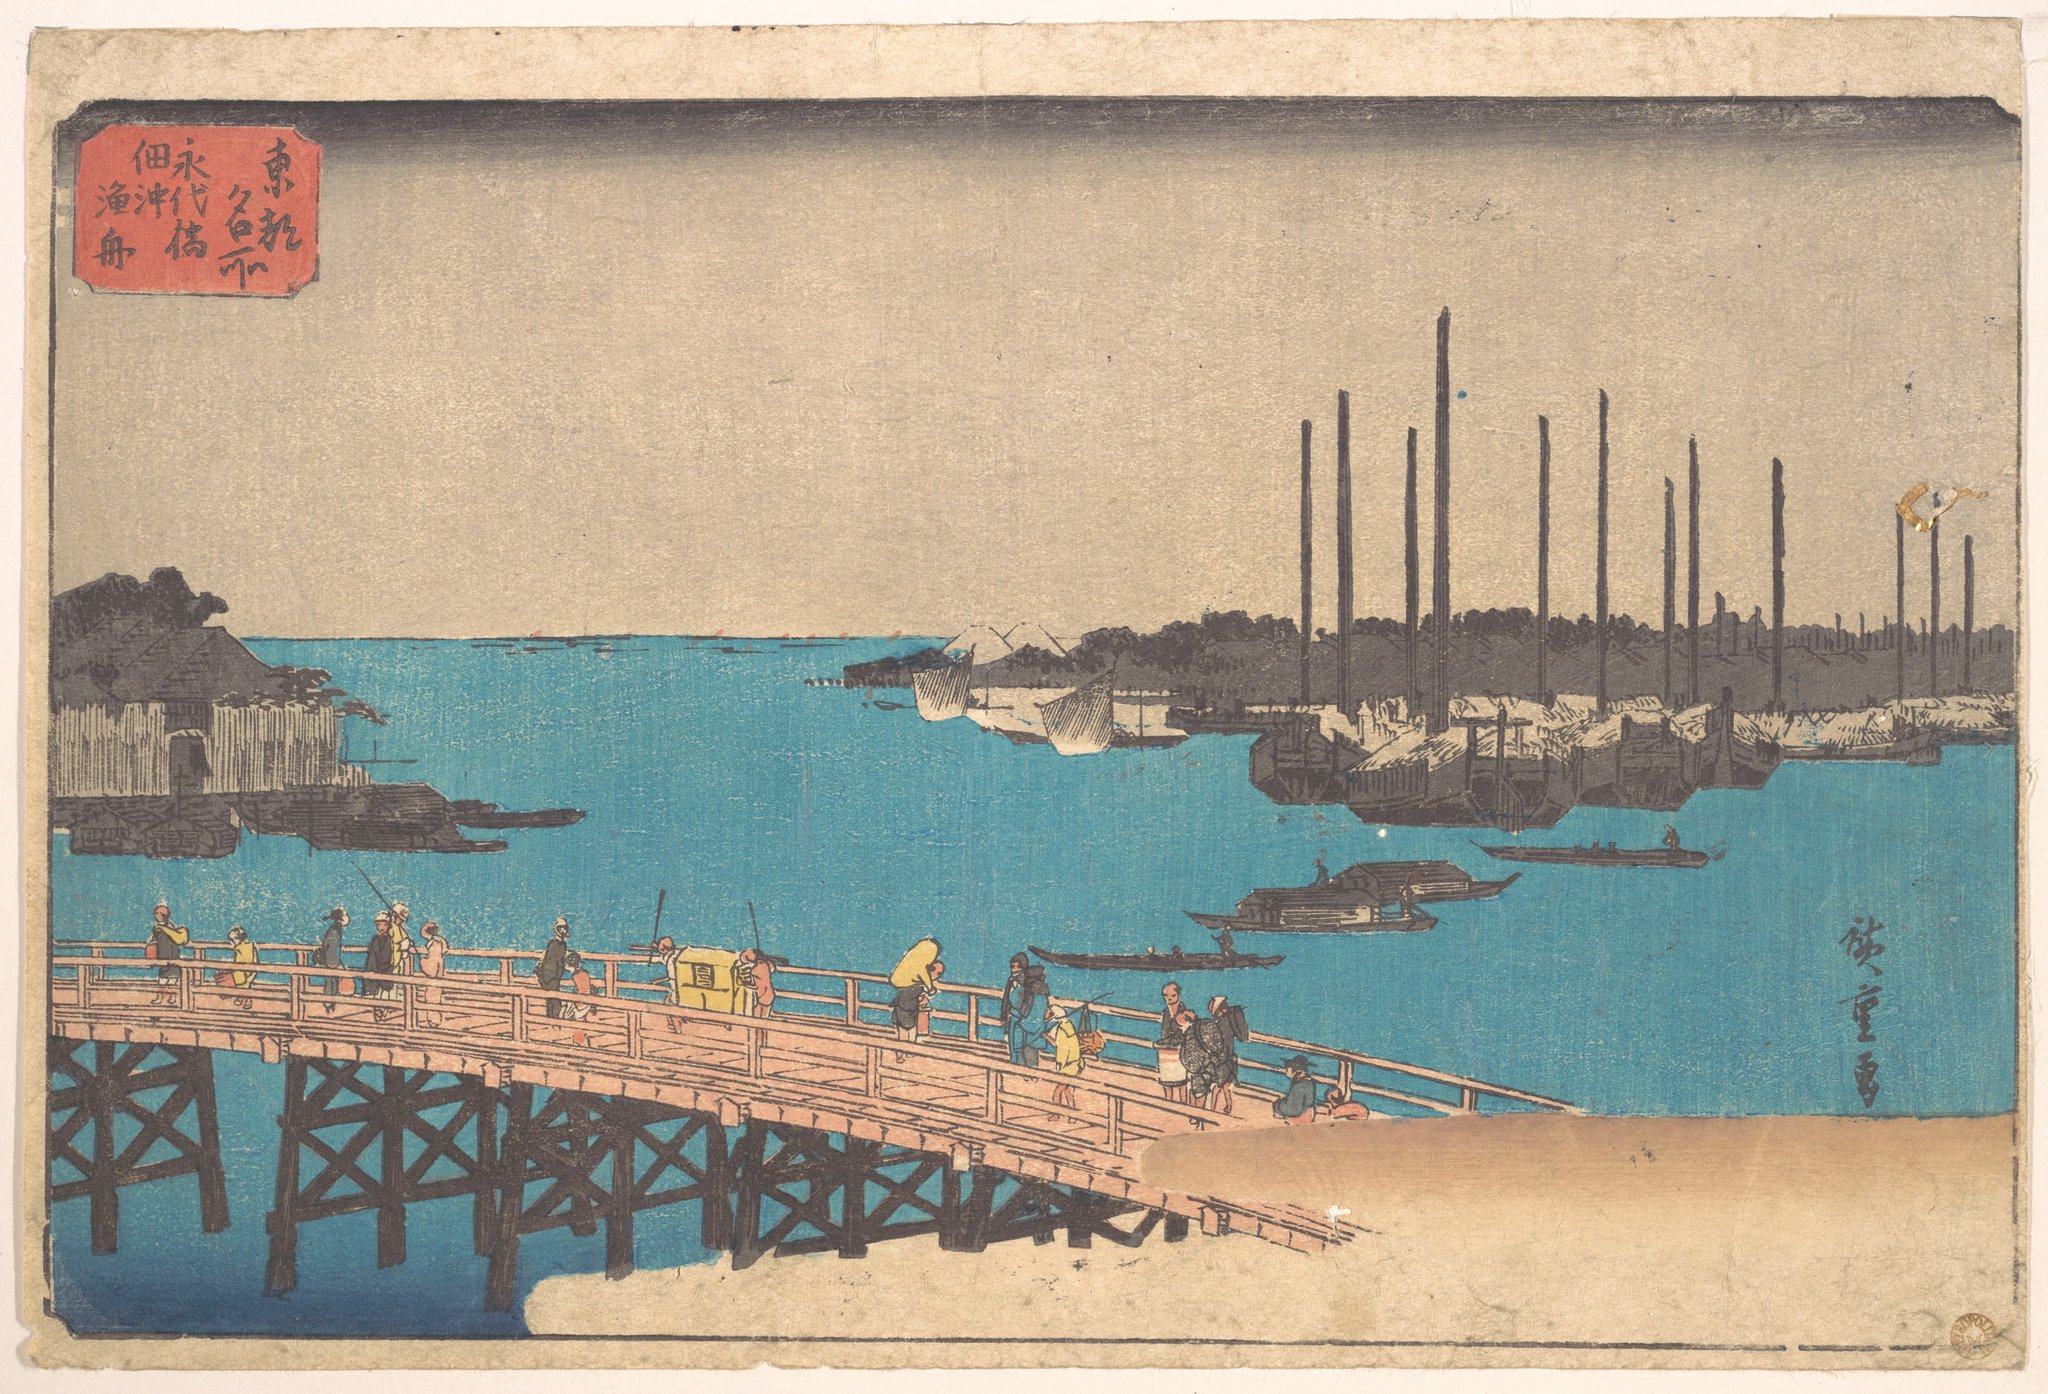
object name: print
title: Eitai Bashi Tsukudajima Ryosen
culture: japanese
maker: utagawa hiroshige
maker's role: artist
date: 1835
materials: ink, paper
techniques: woodblock print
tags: bridges,rivers,working,ships